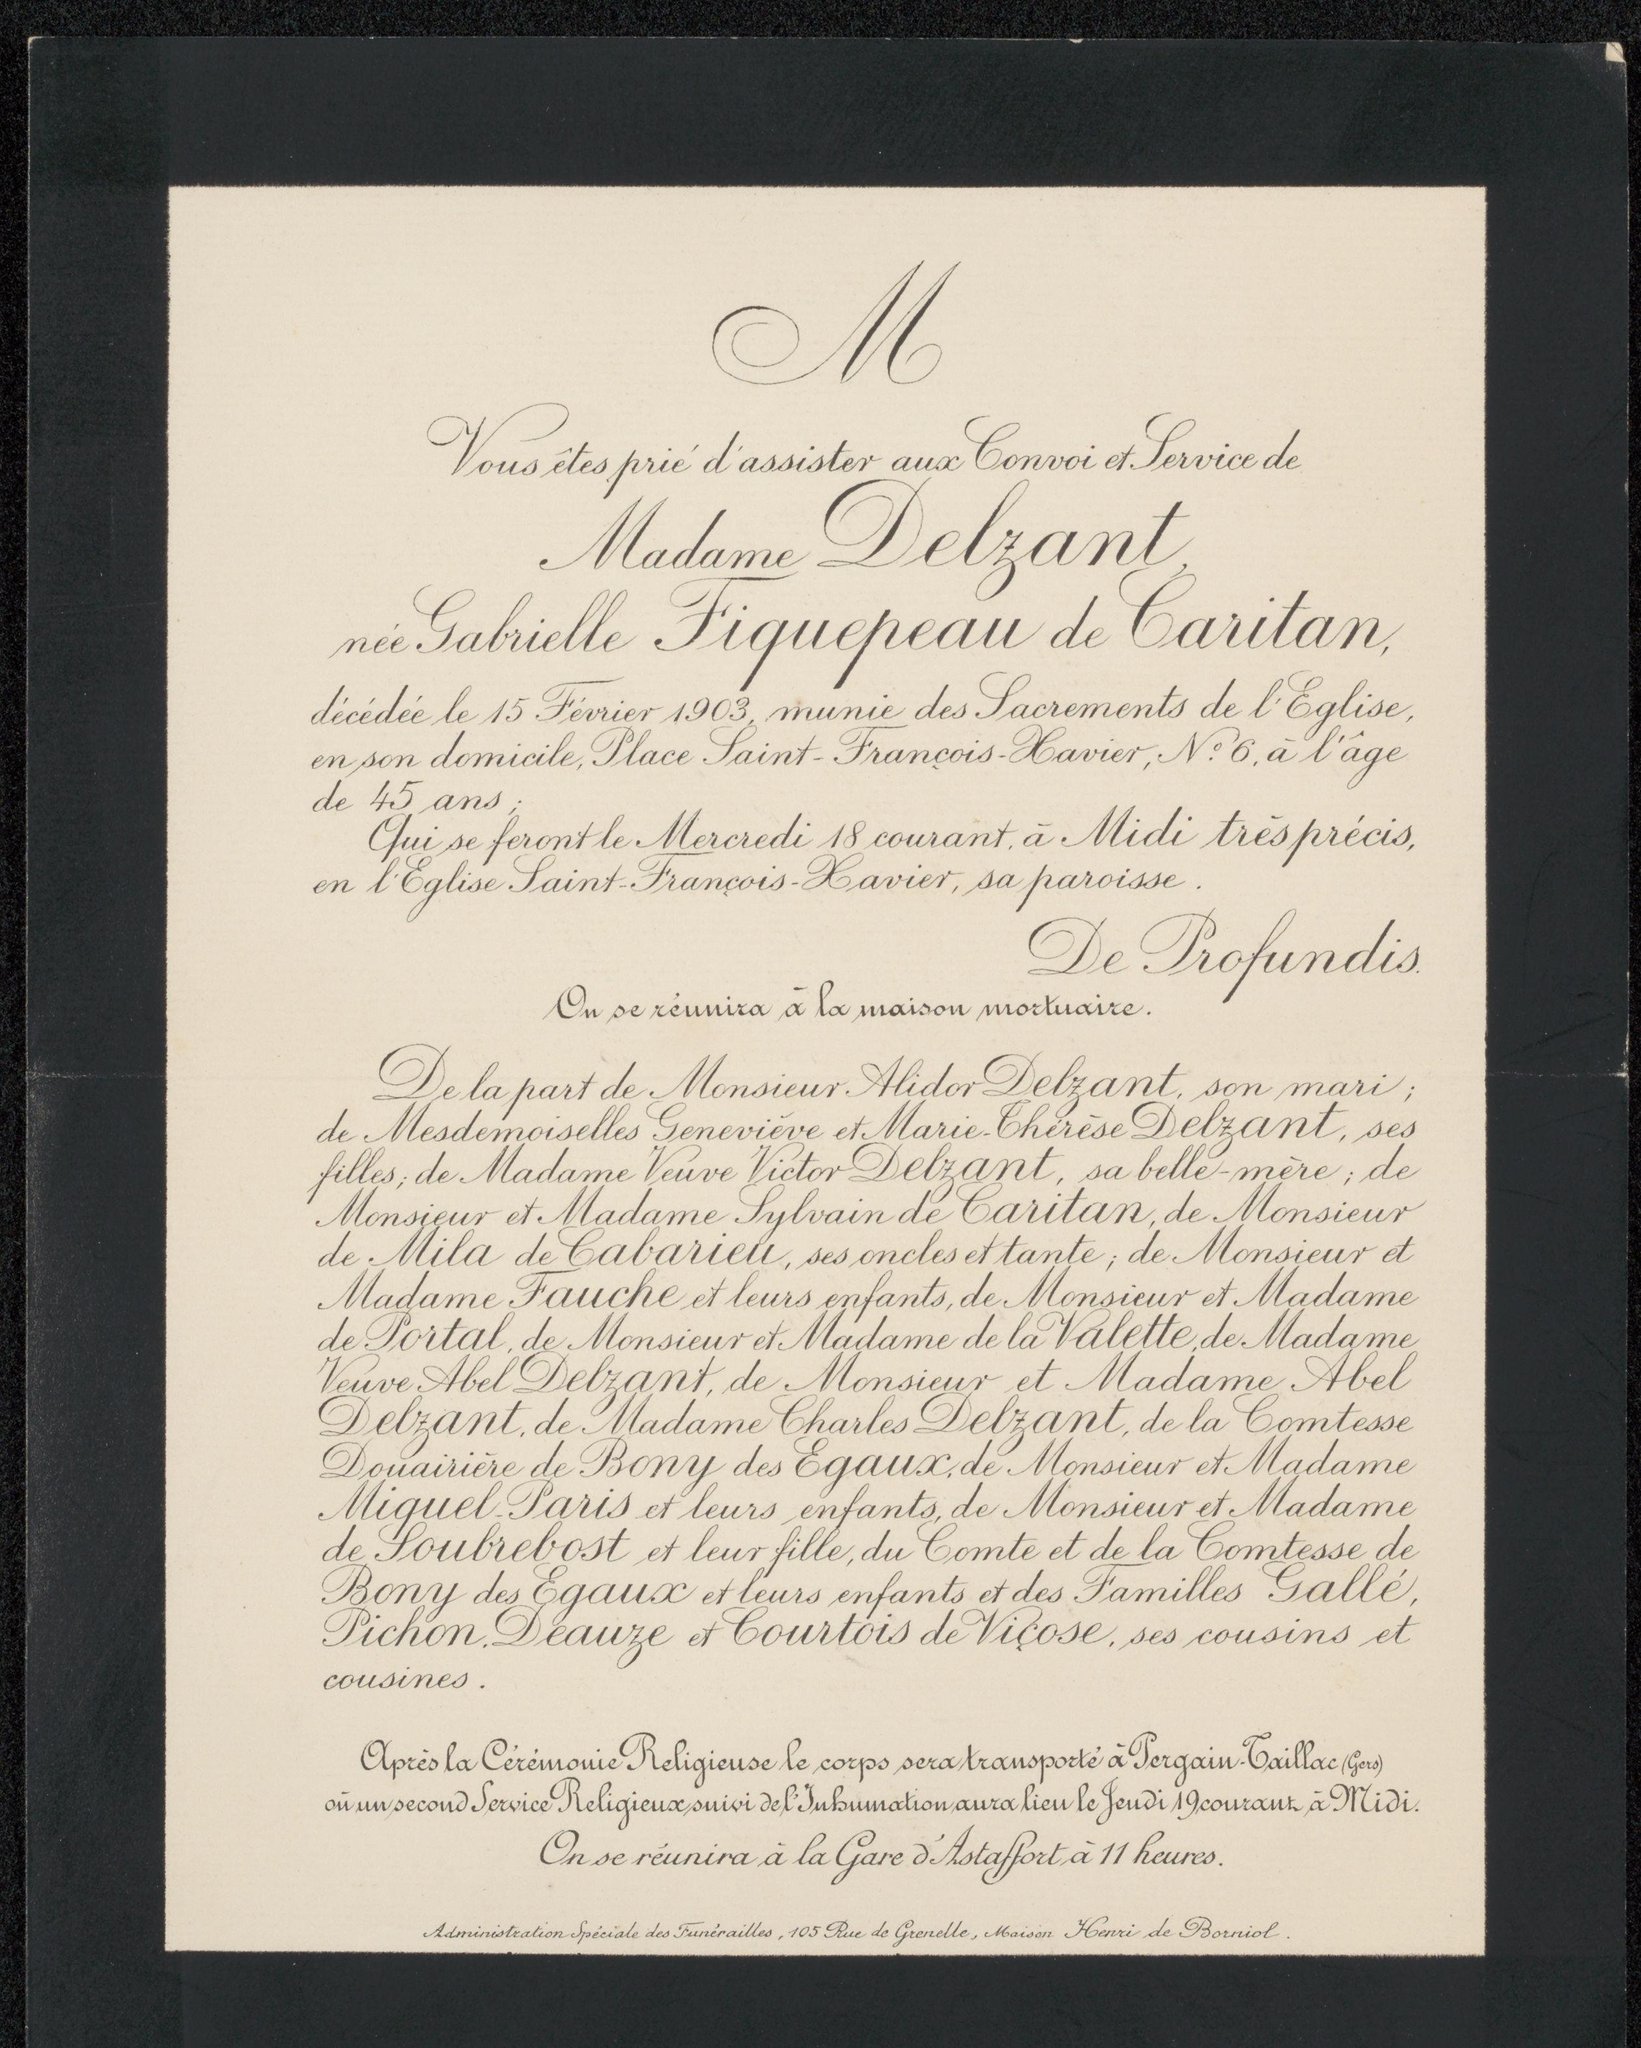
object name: overlijdensbericht, overlijdensadvertentie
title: Overlijdensbericht aan Philip Zilcken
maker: Anonymous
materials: cardboard, ink, pencil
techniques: pen, printing, writing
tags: painter, draughtsman, philip zilcken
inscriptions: collector's mark: ‘RPK’